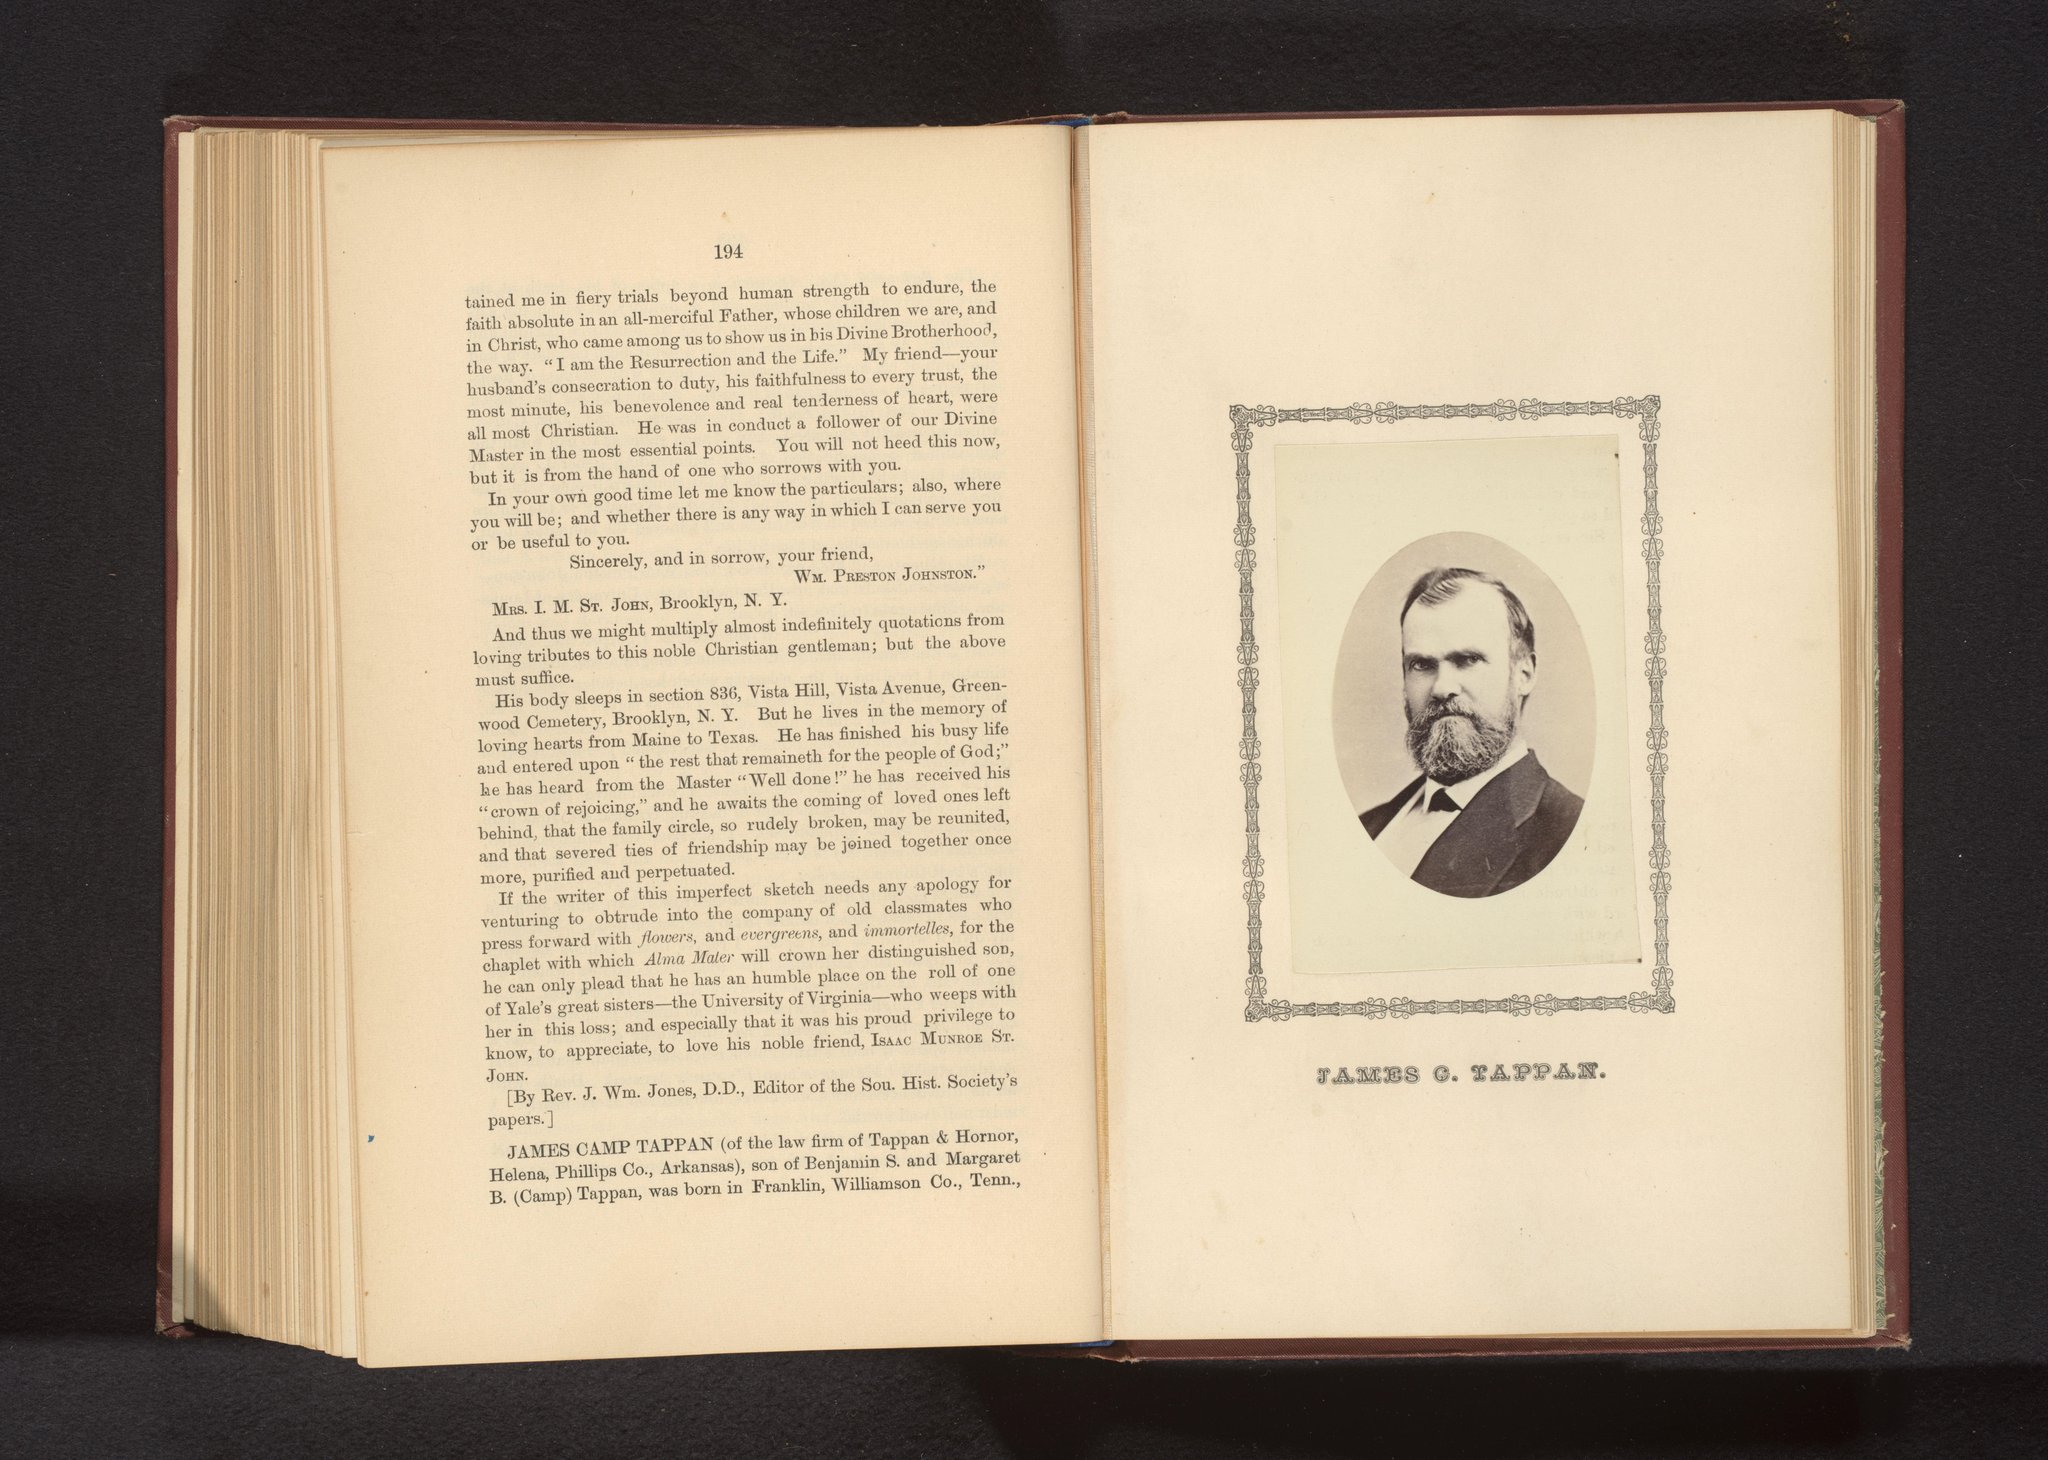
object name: page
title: James C. Tappan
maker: Anonymous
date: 1876-1881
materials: photographic support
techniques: albumen print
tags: commander-in-chief, general, marshal